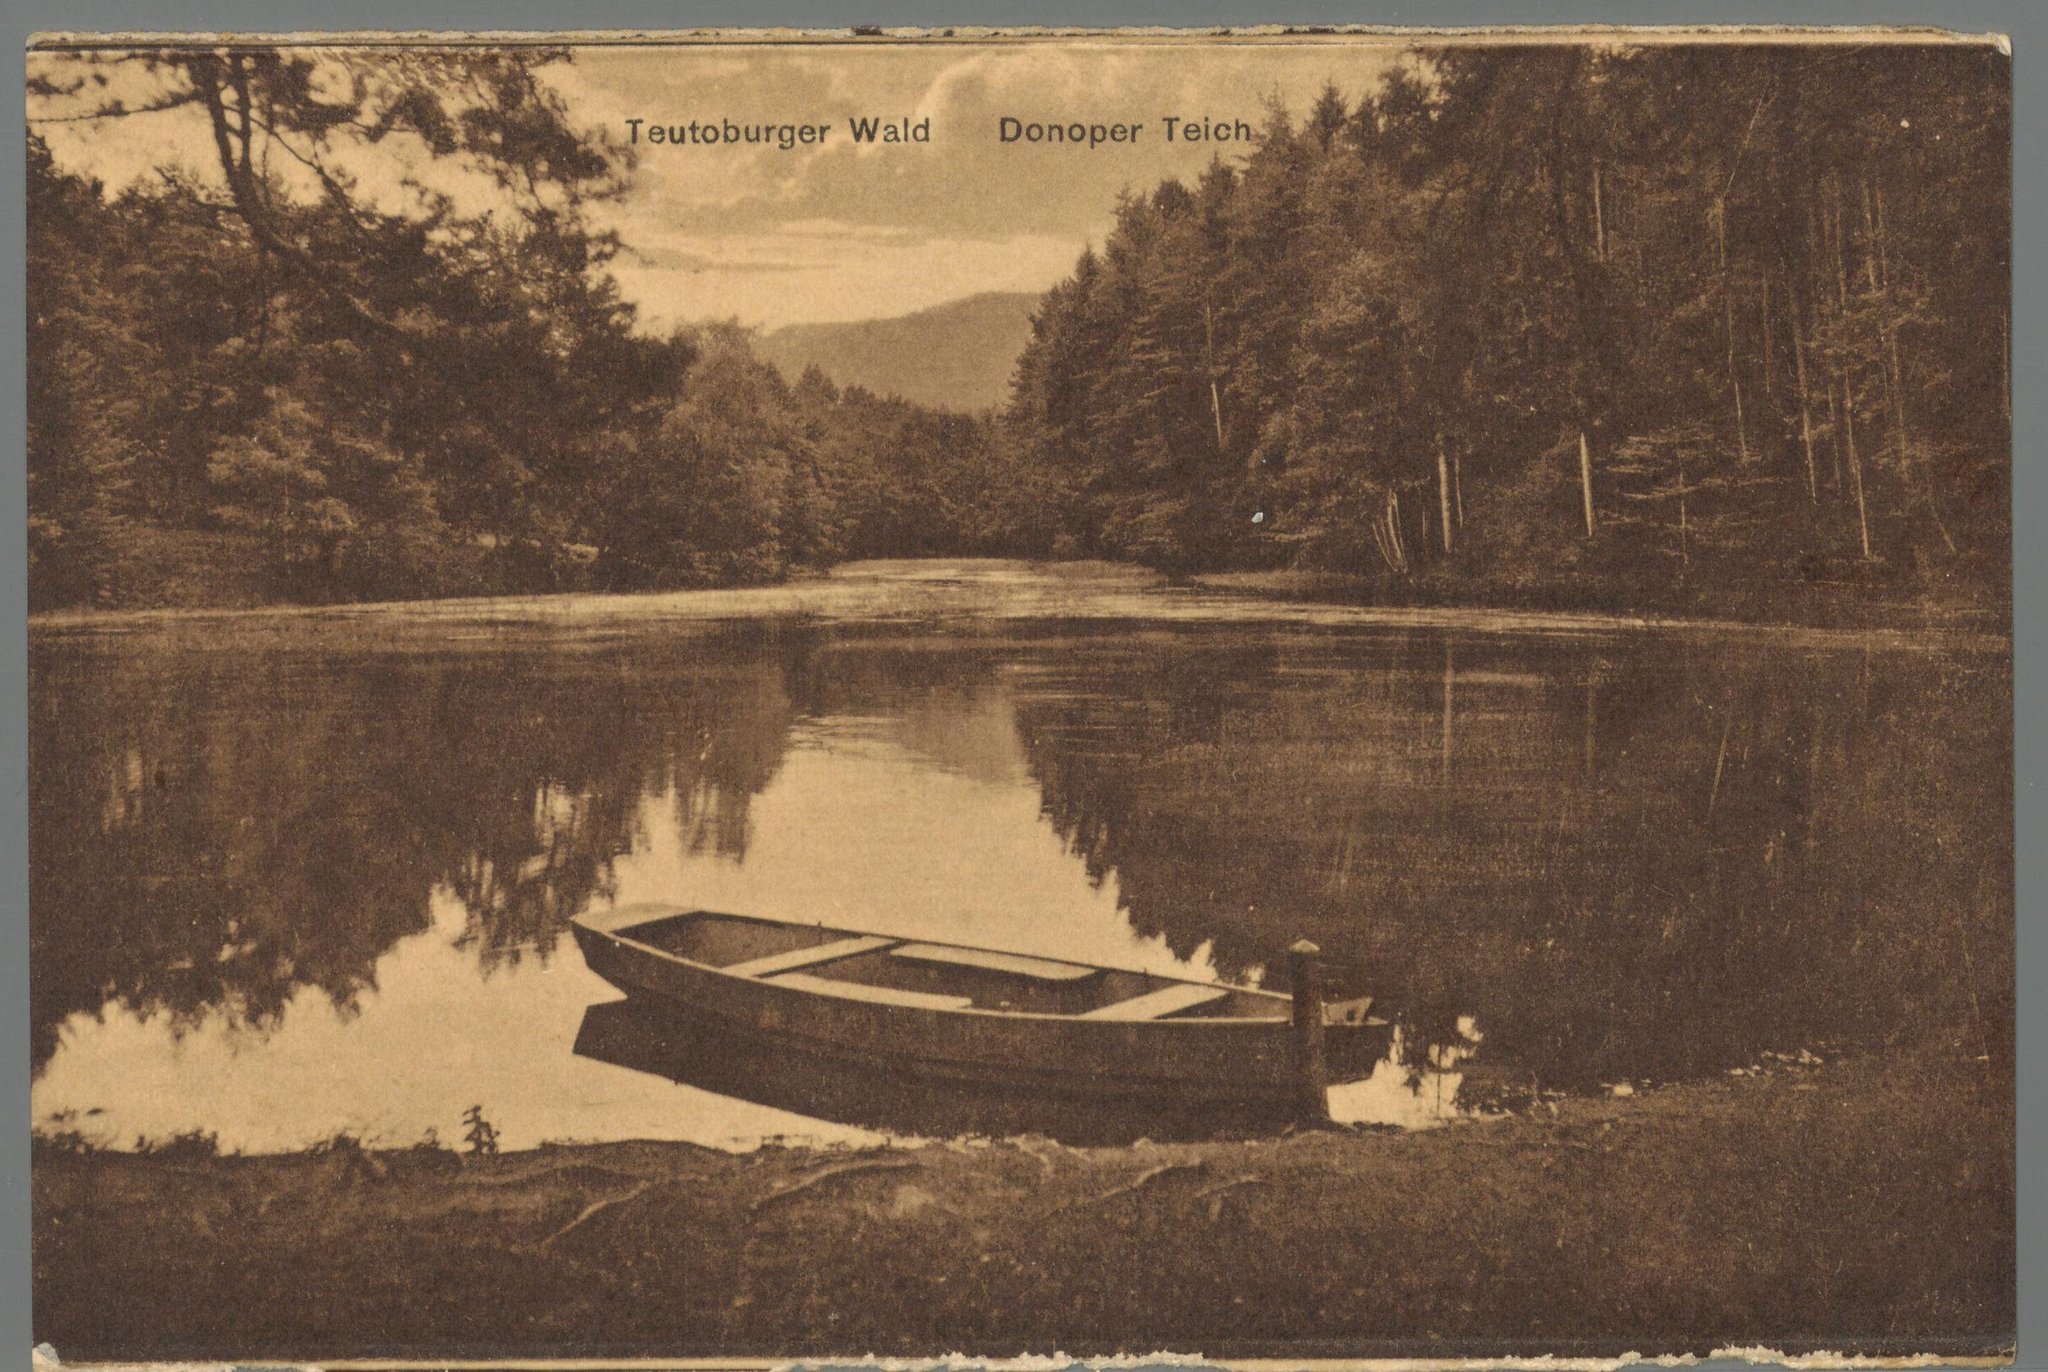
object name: ansichtkaart, prentbriefkaart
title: Teutoburger Wald. Donoper Teich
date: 1927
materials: cardboard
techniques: photograph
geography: teutoburgerwoud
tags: lake, forest, wood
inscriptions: date